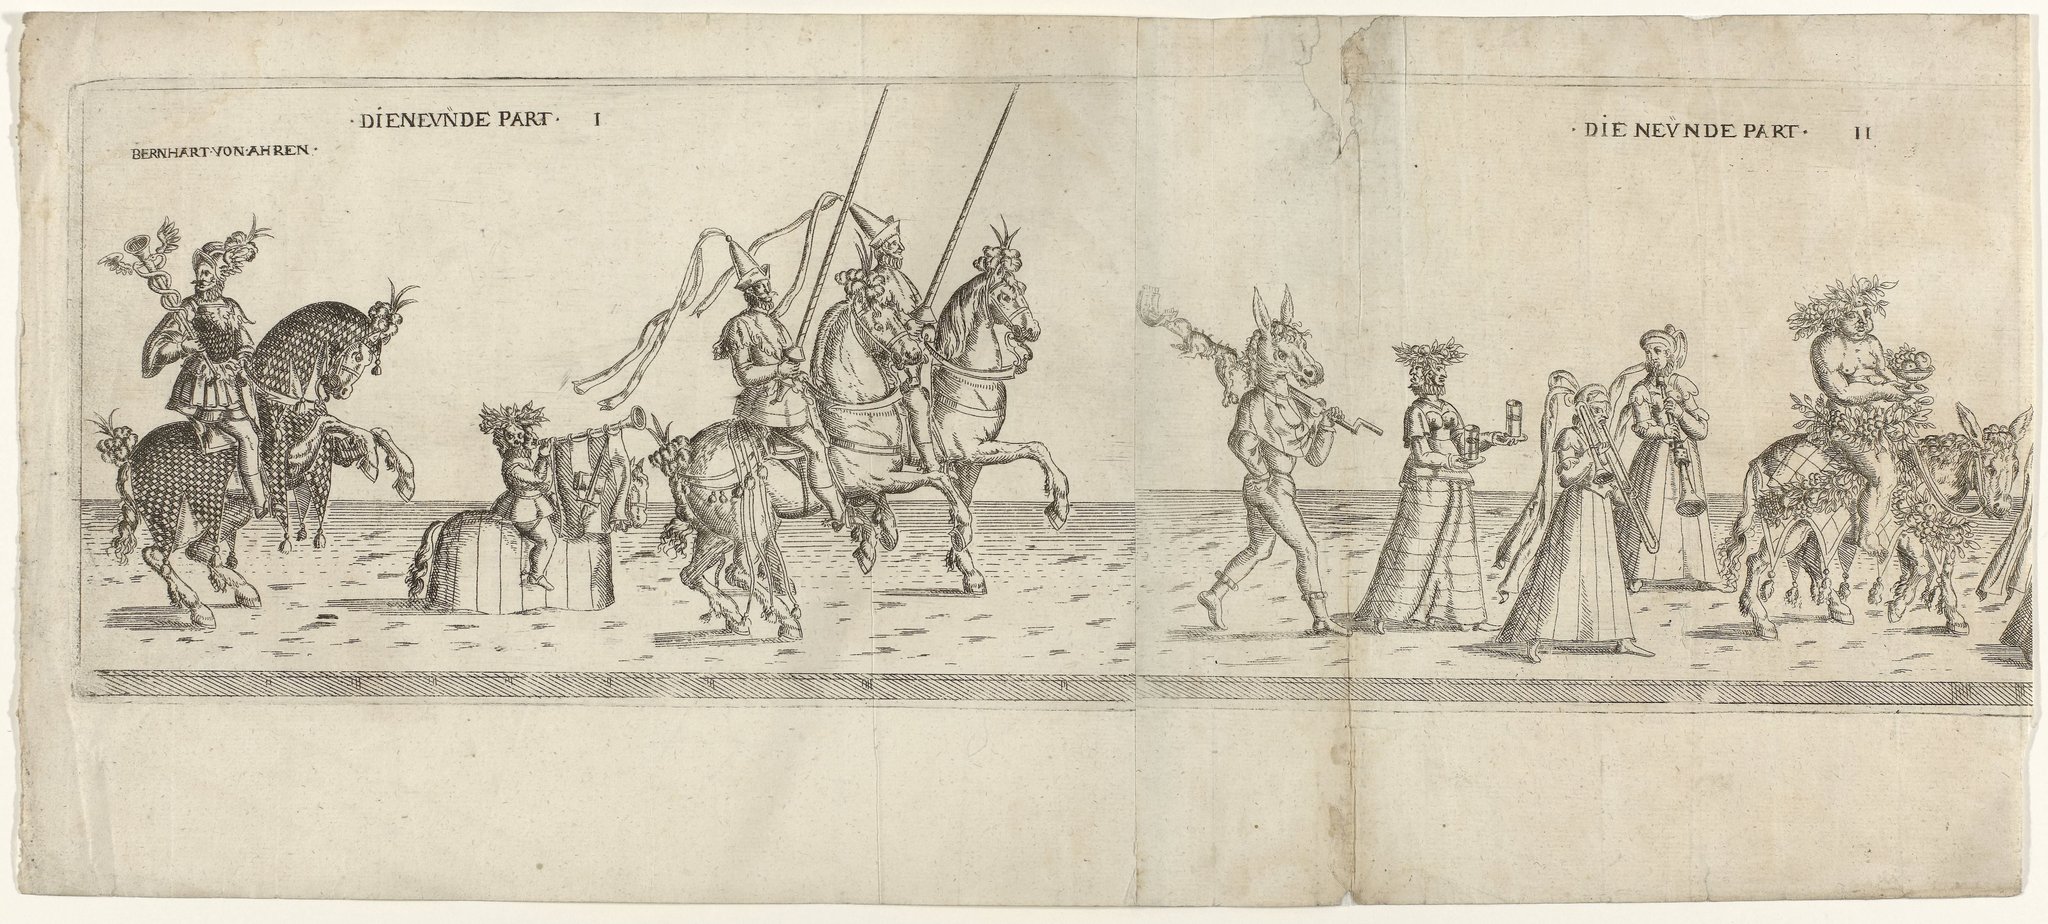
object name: print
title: Die neunde Part I en II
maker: Anonymous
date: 1553-1586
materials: paper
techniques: etching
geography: germany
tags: riding a horse, ass, or mule; rider, horseman, dress-up party, specific aspects, allegorical aspects of bacchus; bacchus as patron, rejoicing on special occasions (+ parade, pageant, cavalcade ~ festive activities), janus' head, two-faced head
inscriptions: collector's mark: Lugt 2228, collector's mark: Lugt 2760